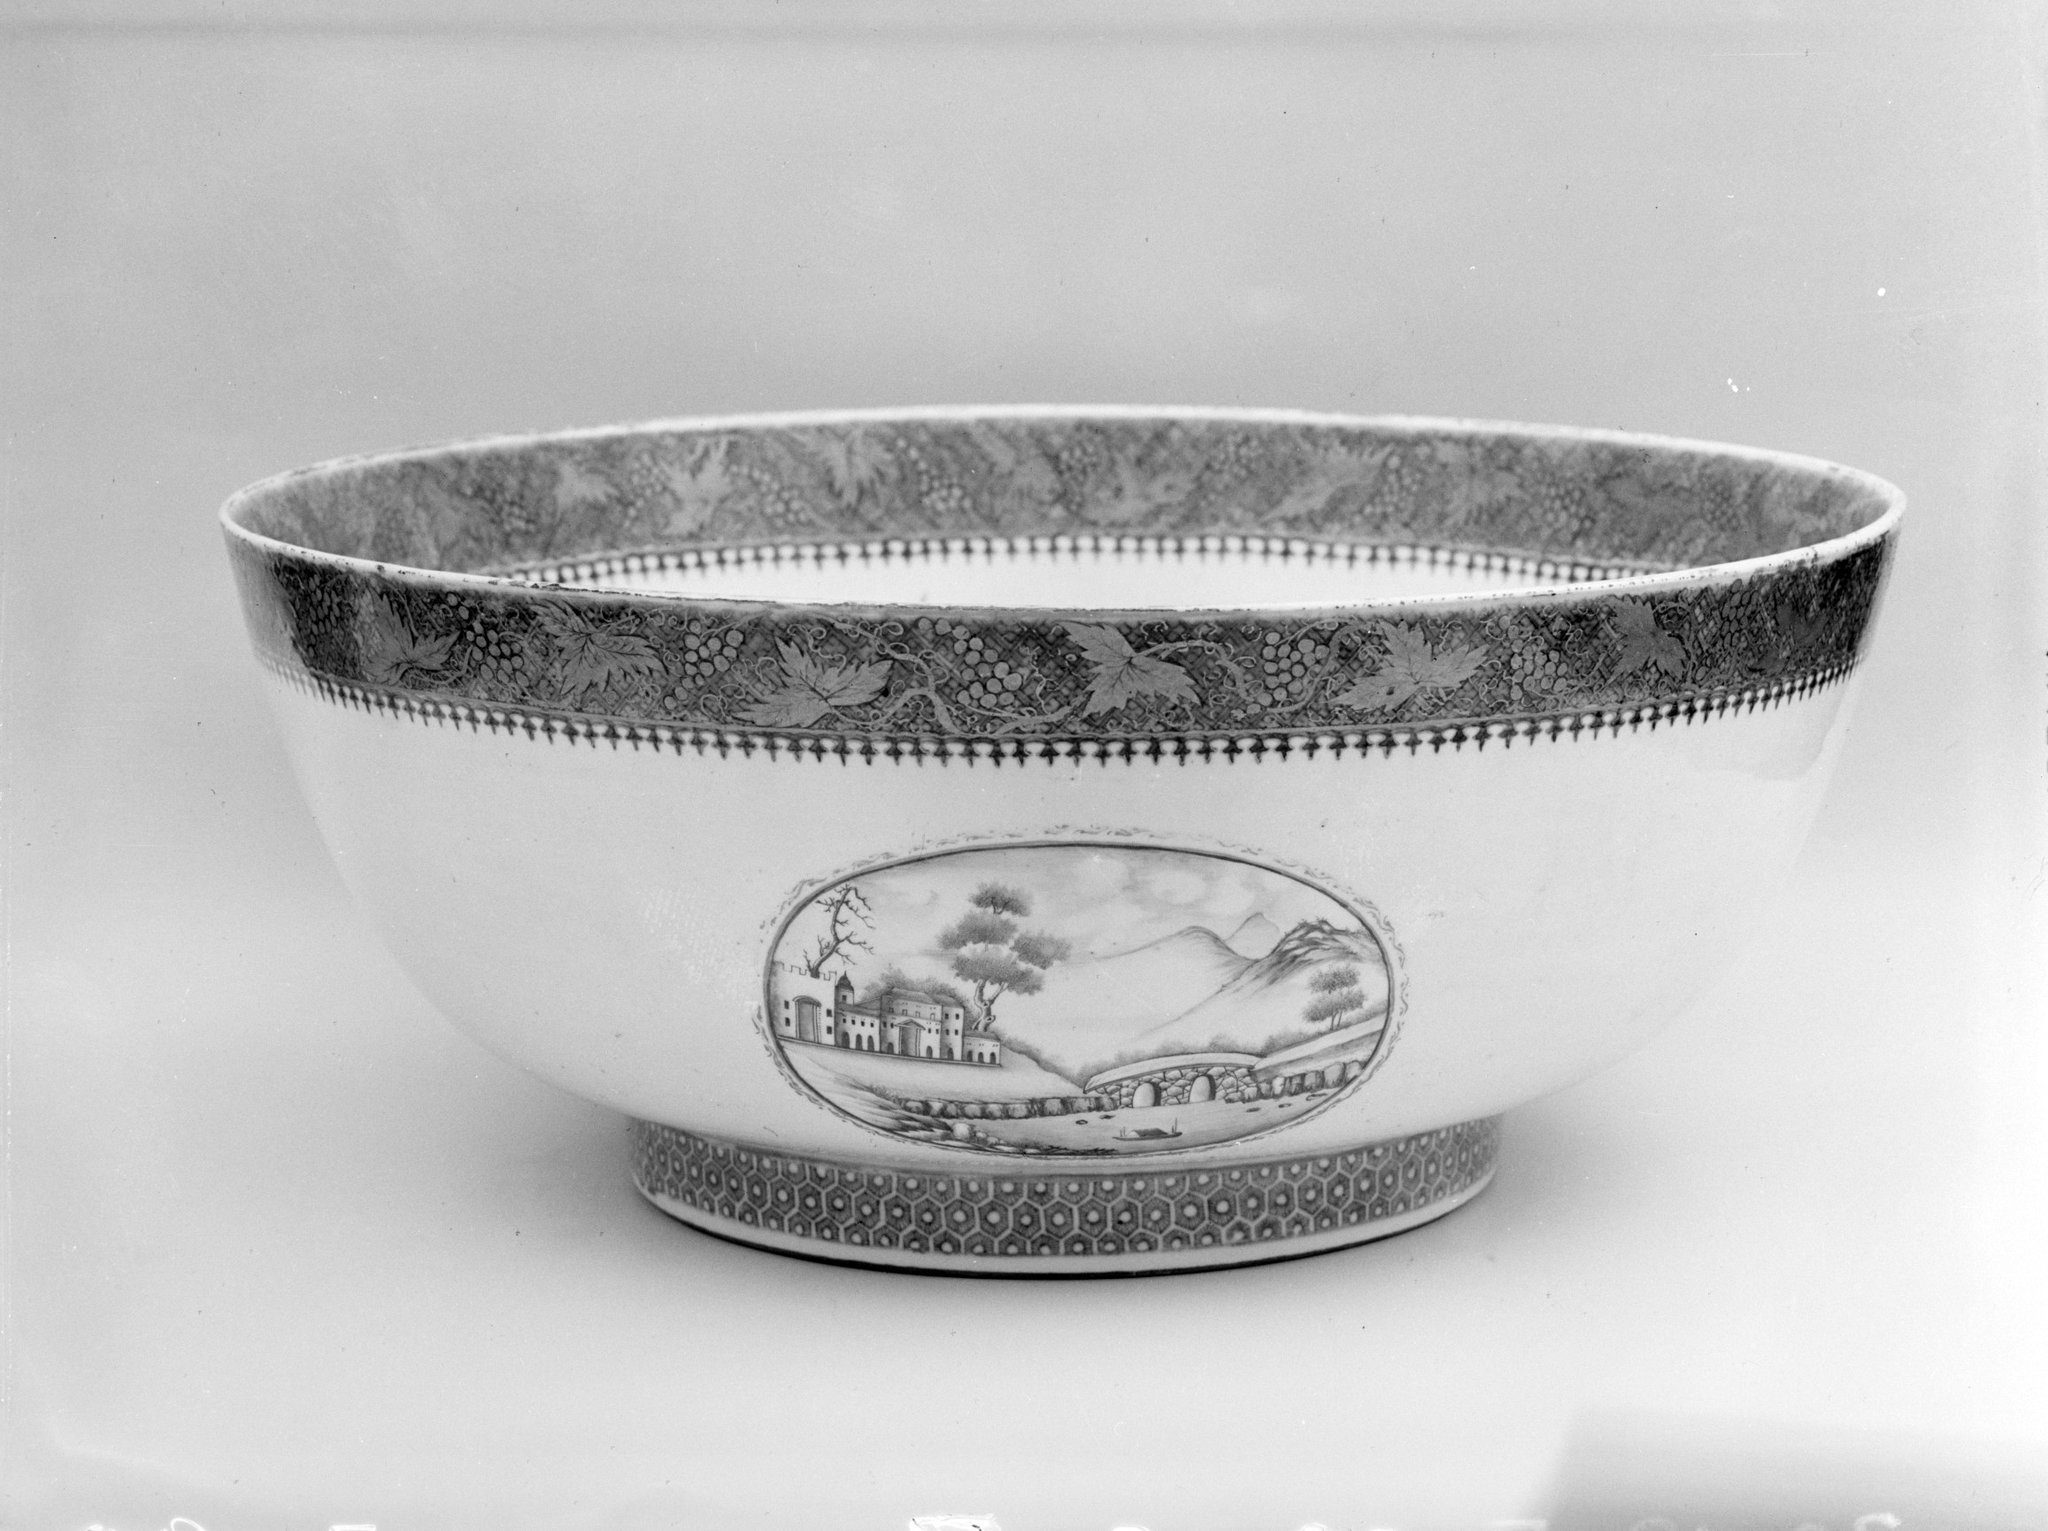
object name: punch bowl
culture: chinese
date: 1770-1800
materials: porcelain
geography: china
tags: grapes,landscapes